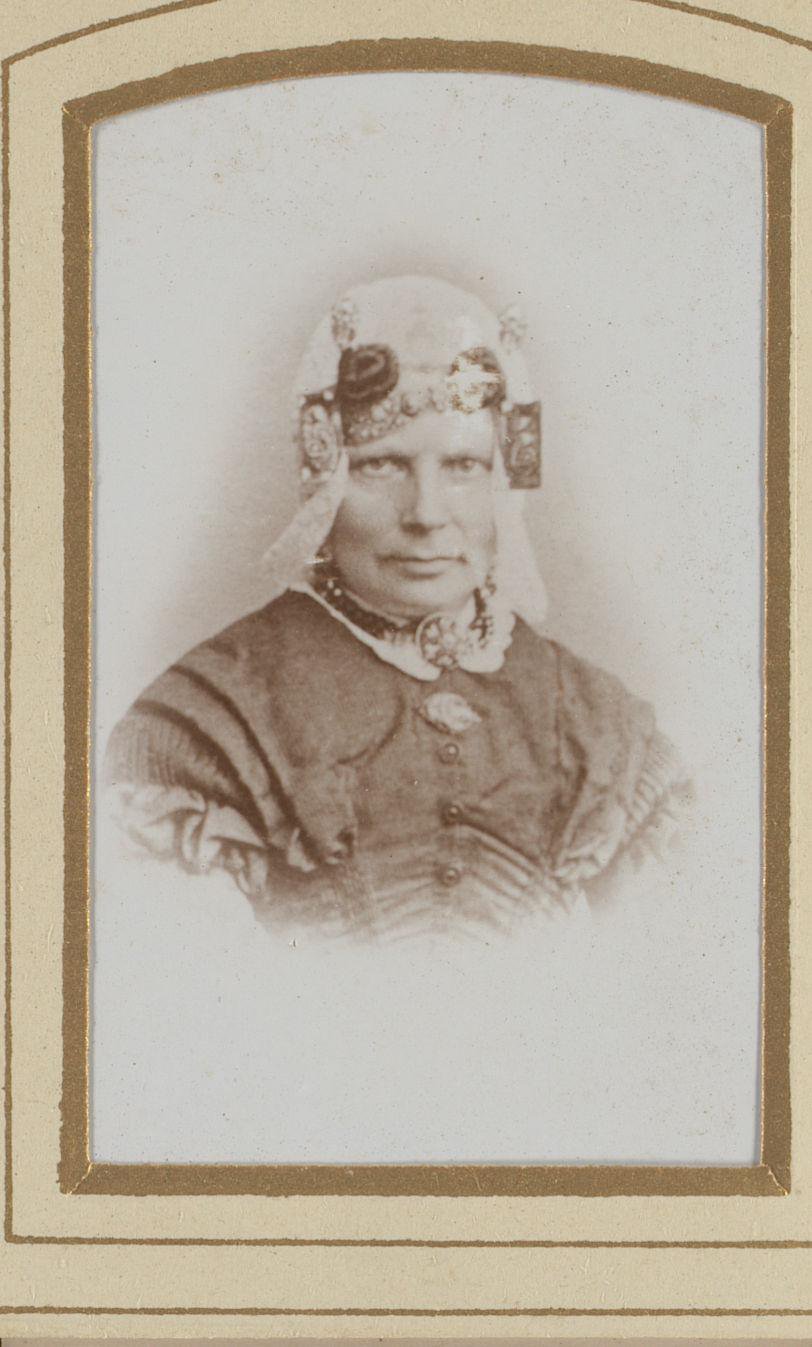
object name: carte de visite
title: Portret van een vrouw met witte klederdrachtmuts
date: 1880-1918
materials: cardboard, photographic support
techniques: collodion silver print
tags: historical persons - bb - woman, head-gear: cap, folk costume, regional costume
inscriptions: inscription: ‘Photographische/ Ateliers/ J. Siewers & Zoon/ Edam/ Hilversum./ Specialiteit in vergrootingen.’